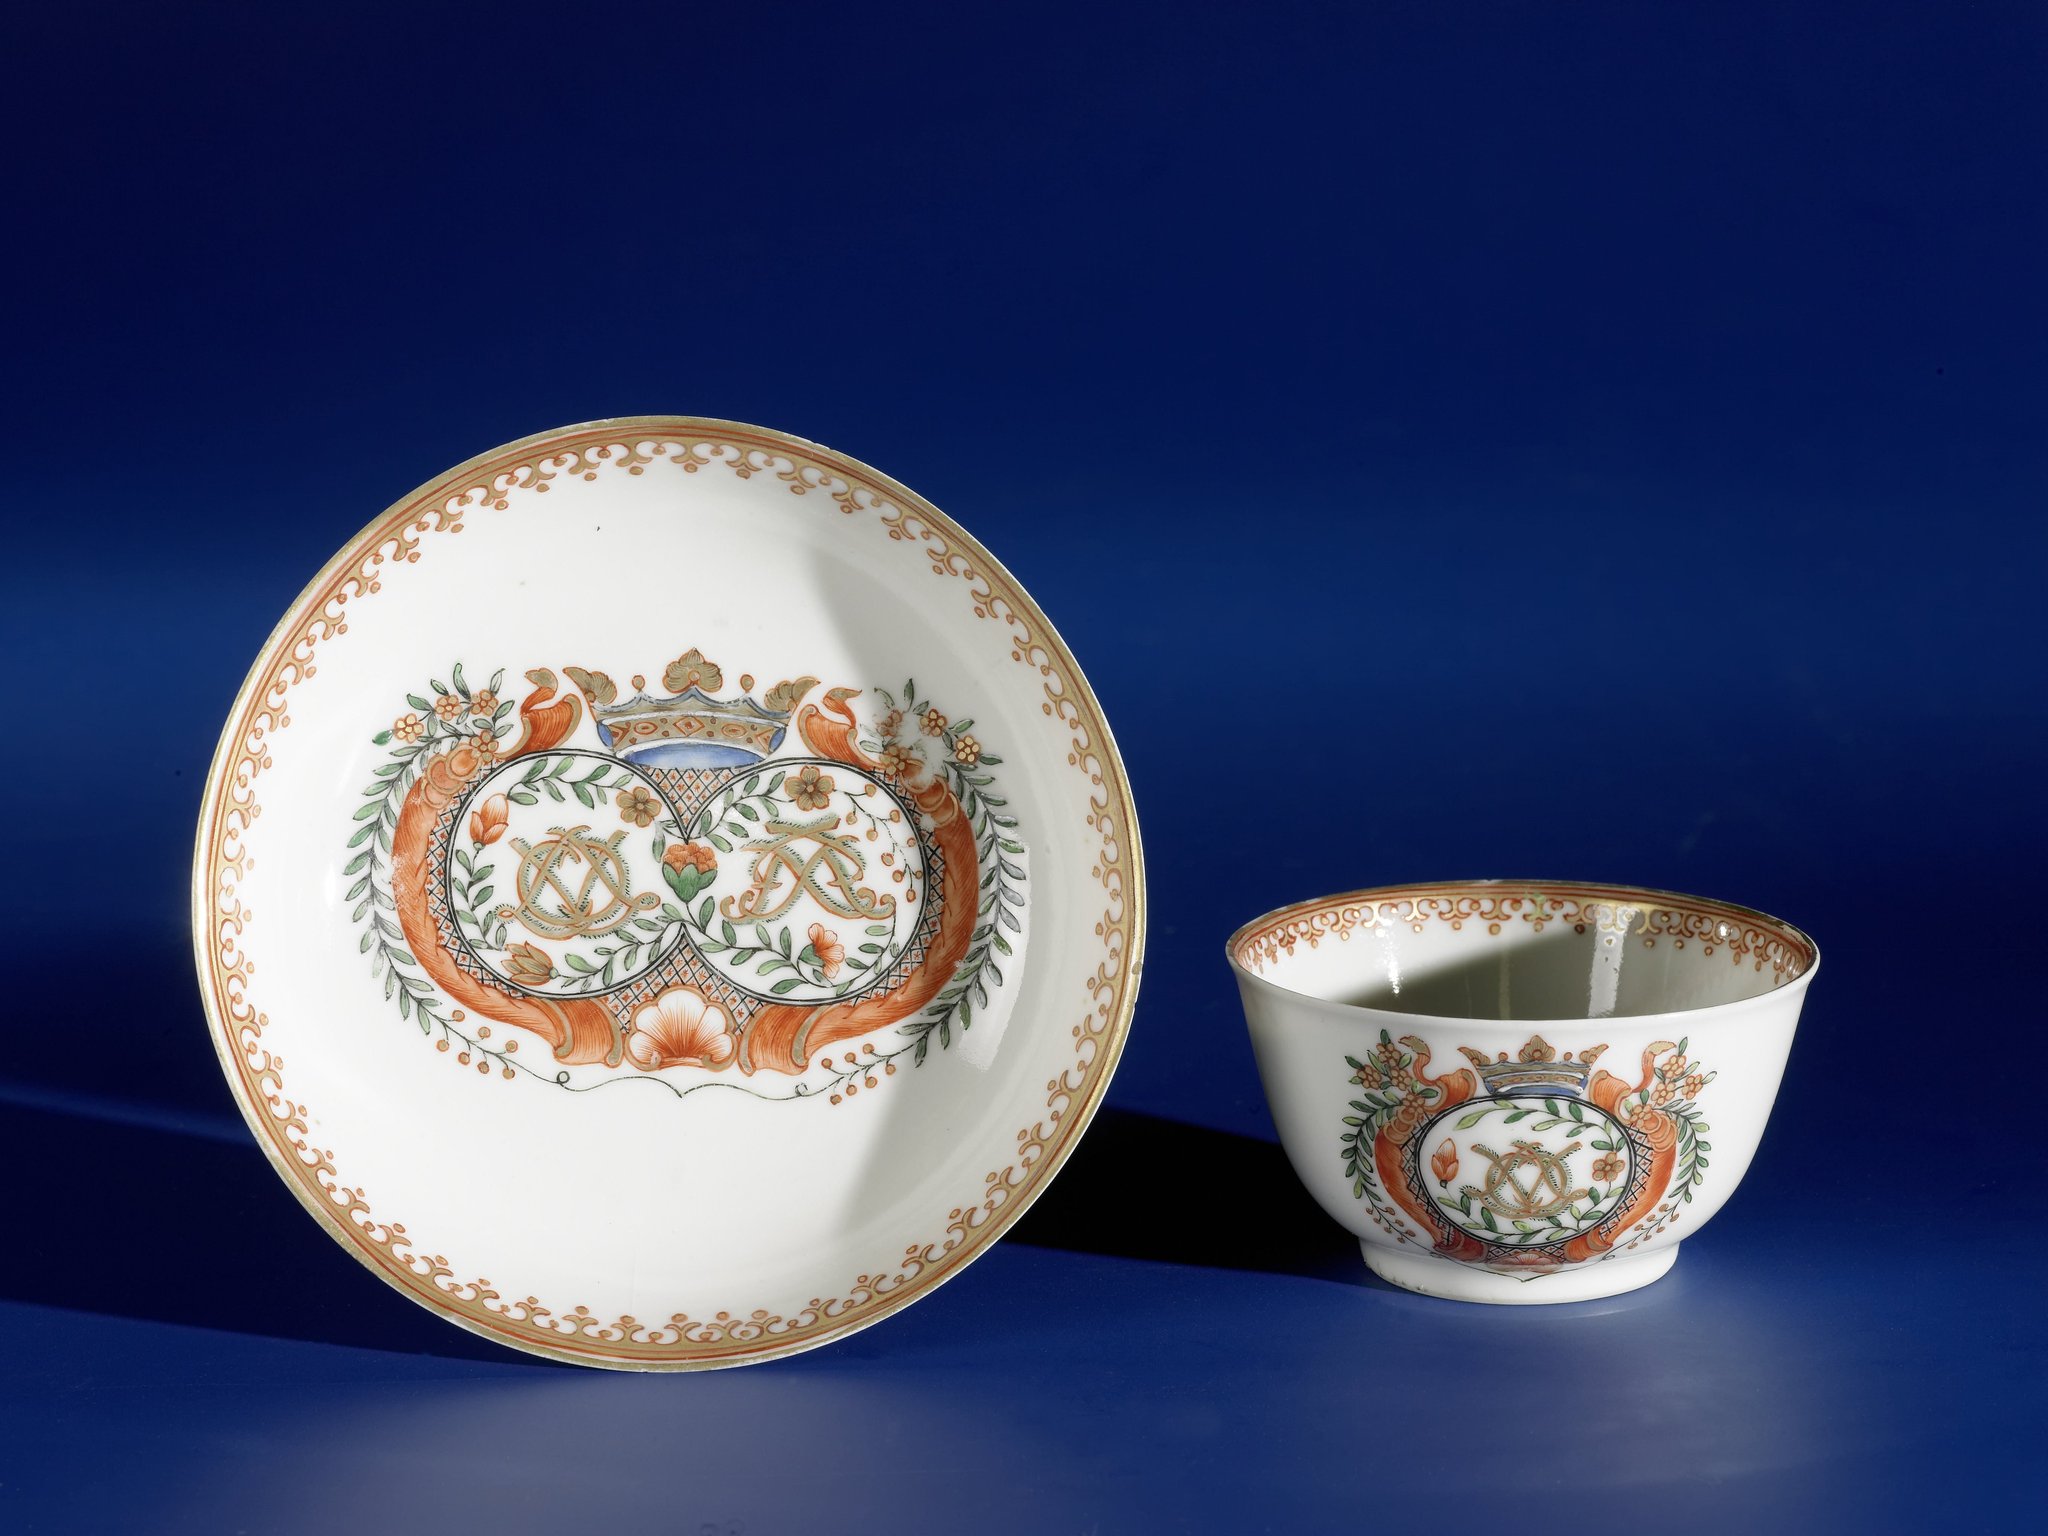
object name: kop en schotel, kop en schotel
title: Bell-shaped cup and saucer with a crowned double monogram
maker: Anonymous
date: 1750-1774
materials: glaze, gold, paint, porcelain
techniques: firing, gilding, turning, vitrification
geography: china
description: Klokvormige kop en schotel van porselein, beschilderd op het glazuur in blauw, rood, groen, zwart en goud. Op het plat een gekroon dubbel monogram met links 'C.V.L.' en rechts 'F.S.A.' met om de letters bloemtakken. Om het monogram een schelpmotief en bladranken. Op de binnenrand een decoratieve band. Wapenporselein met emailkleuren.